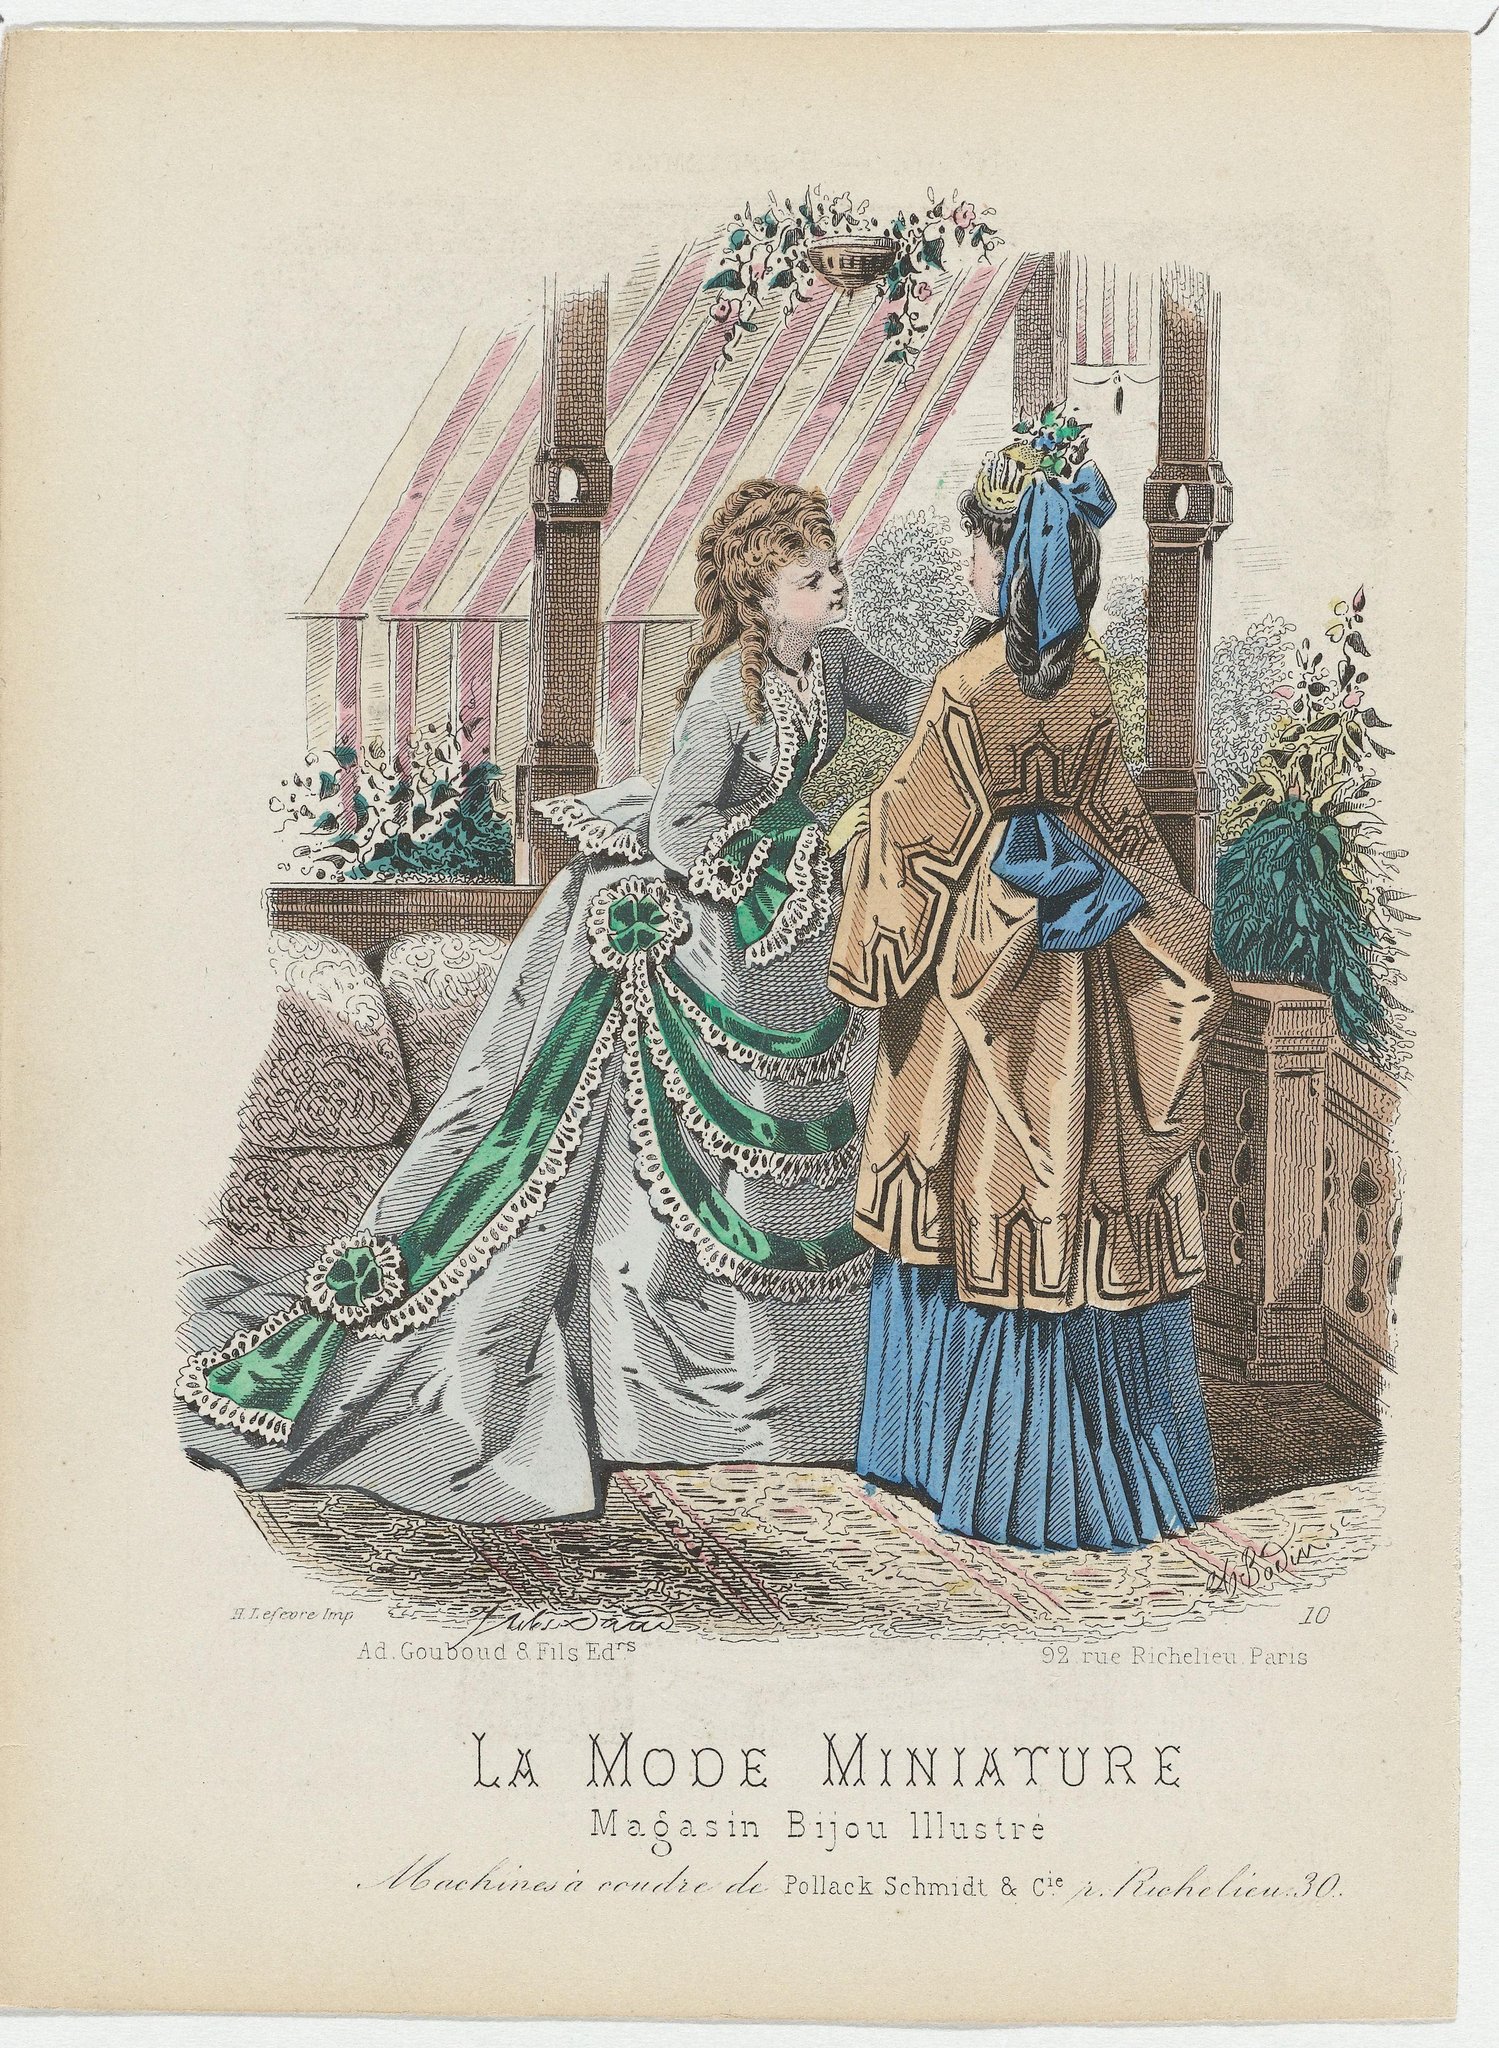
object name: fashion print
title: La Mode Miniature, 1872, No. 10 : Machines à coudr (...)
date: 1872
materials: paper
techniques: engraving, hand coloring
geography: paris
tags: head-gear (+ women's clothes), fashion plates, skirt (+ women's clothes), dress, gown (+ women's clothes), necklace (+ women's clothes)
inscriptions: title: ‘La Mode Miniature Magasin Bijou Illustré’, caption: ‘Machines à coudre de Pollack Schmidt & Cie r. Richelieu. 30’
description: Twee vrouwen staan buiten op een bordes, gekleed in japonnen met tournure. Prent uit het modetijdschrift La Mode Miniature (1872-1873).